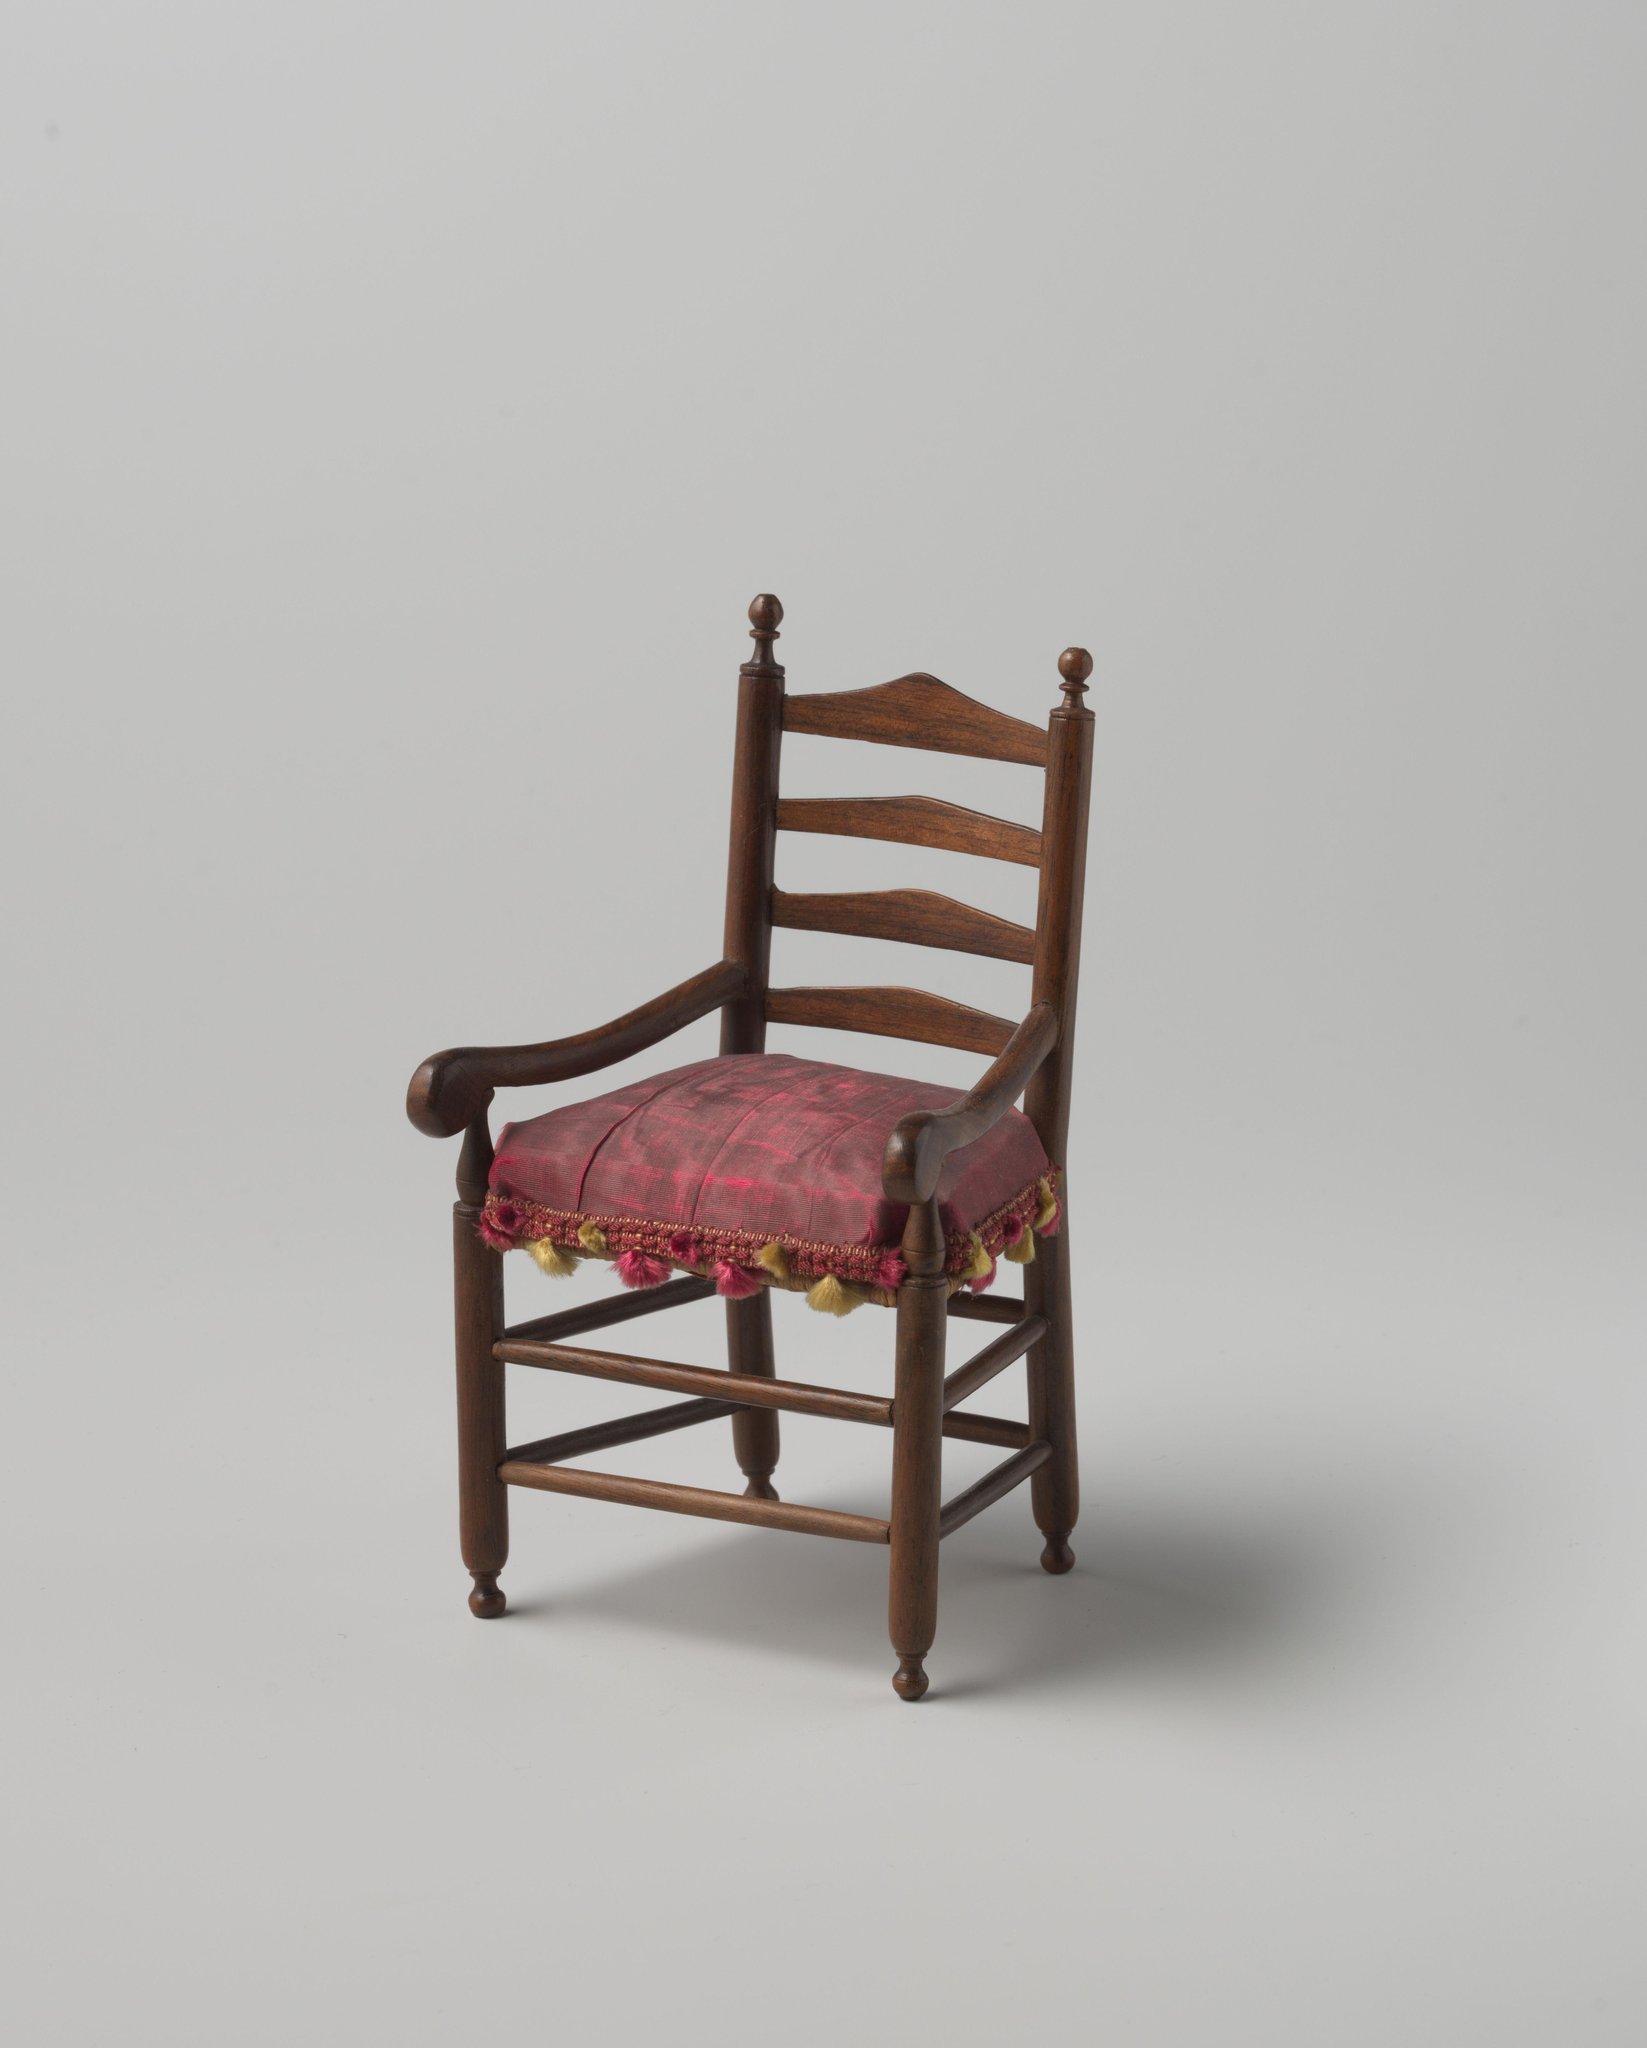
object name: armchair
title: Armstoel (model knopstoel) van notenhout met gladde, gedraaide stijlen en dwarsregels, voorpoten en achterstijlen eindigend in fijn gedraaide knoppen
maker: Anonymous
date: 1690-1710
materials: cardboard, linen, silk, fiber, wood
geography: amsterdam